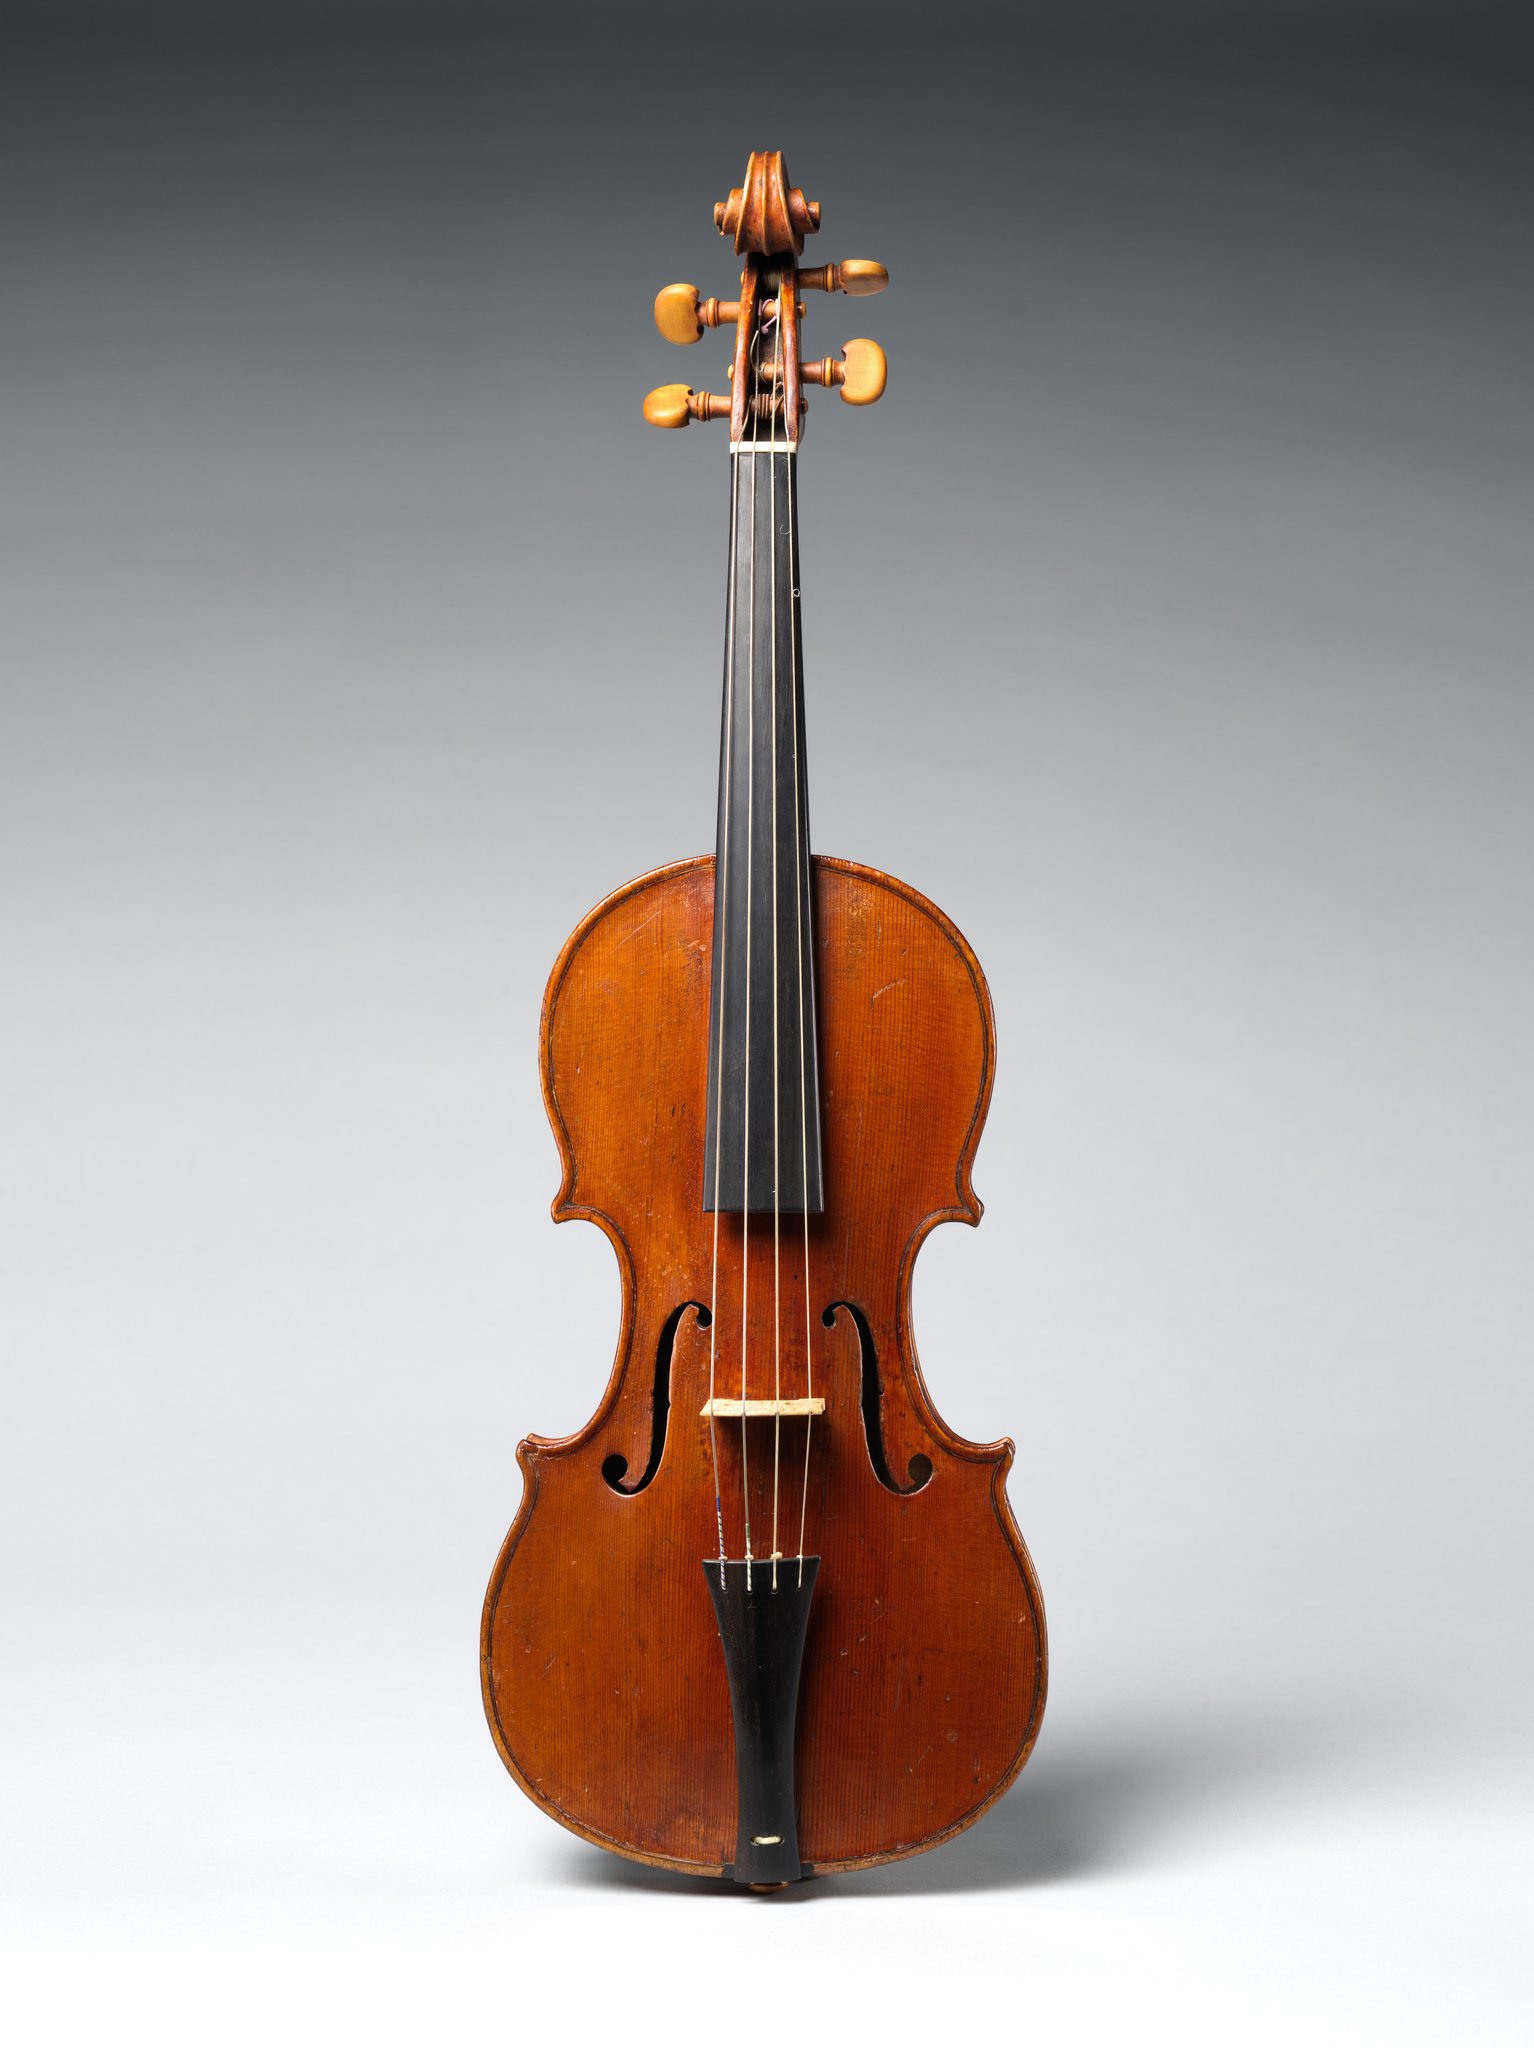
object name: violino piccolo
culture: british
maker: joseph hill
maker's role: maker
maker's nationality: british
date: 1750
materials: wood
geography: united states